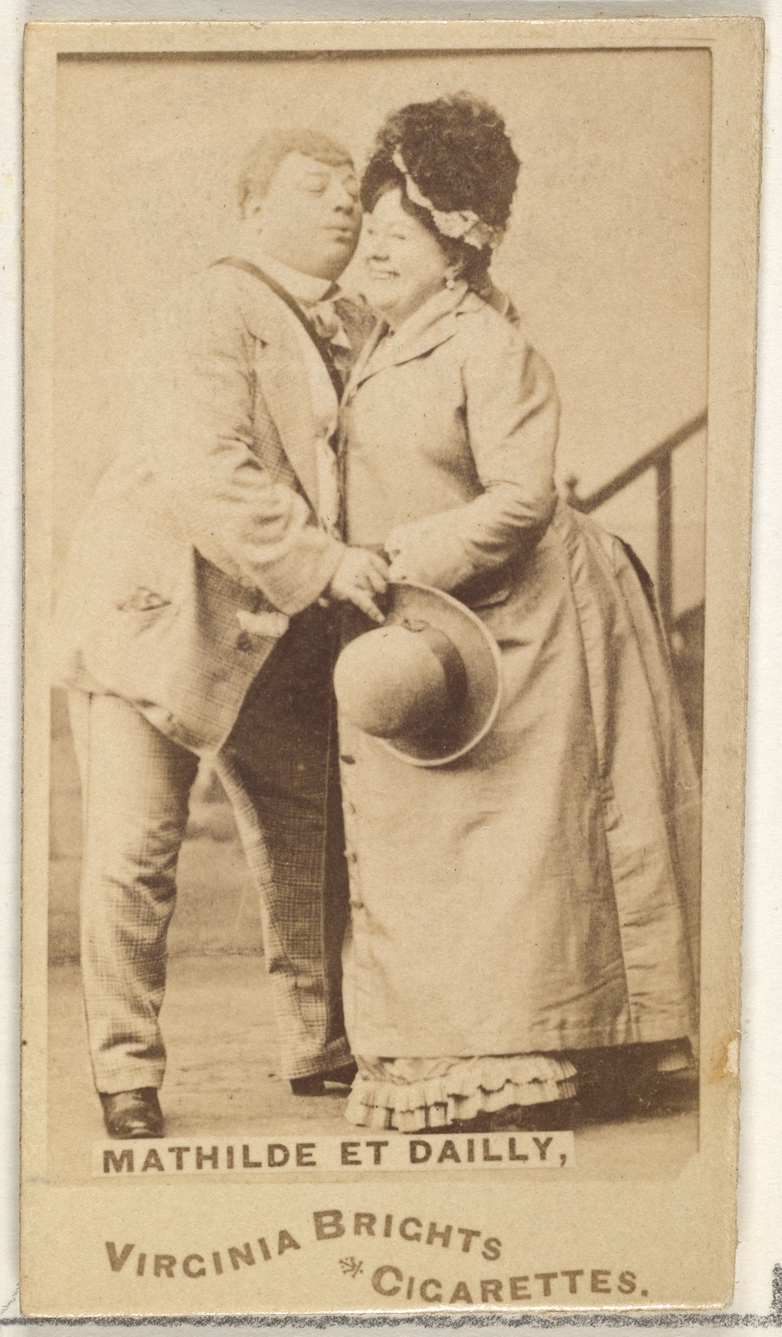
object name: photograph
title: Mathilde et Dailly, from the Actors and Actresses series (N45, Type 1) for Virginia Brights Cigarettes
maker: allen & ginter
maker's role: publisher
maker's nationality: american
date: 1888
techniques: albumen silver print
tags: men,portraits,women,actresses